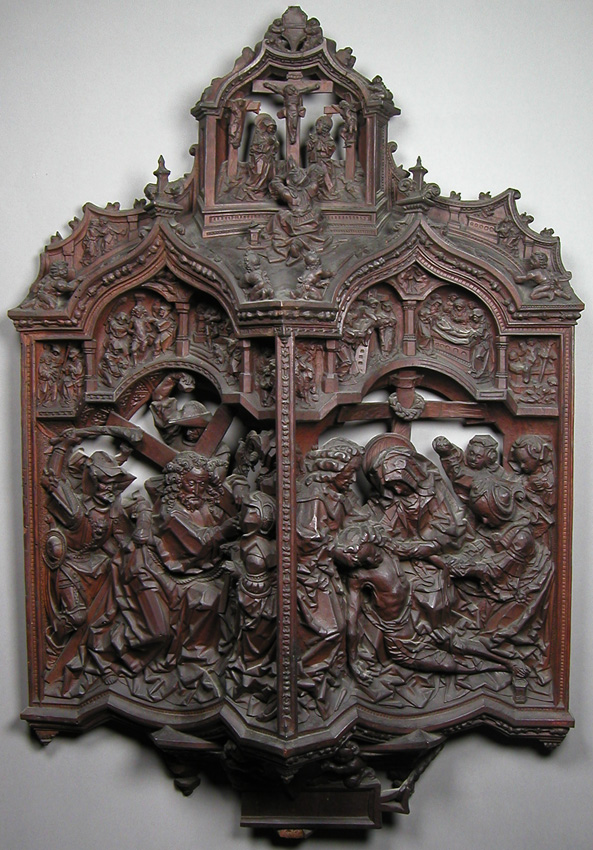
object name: relief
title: Scenes from the Life of Christ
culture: spanish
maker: gil de siloe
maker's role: artist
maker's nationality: spanish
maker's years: 1475-1505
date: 1401-1800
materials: wood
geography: spain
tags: bearing the cross,crucifixion,entombment